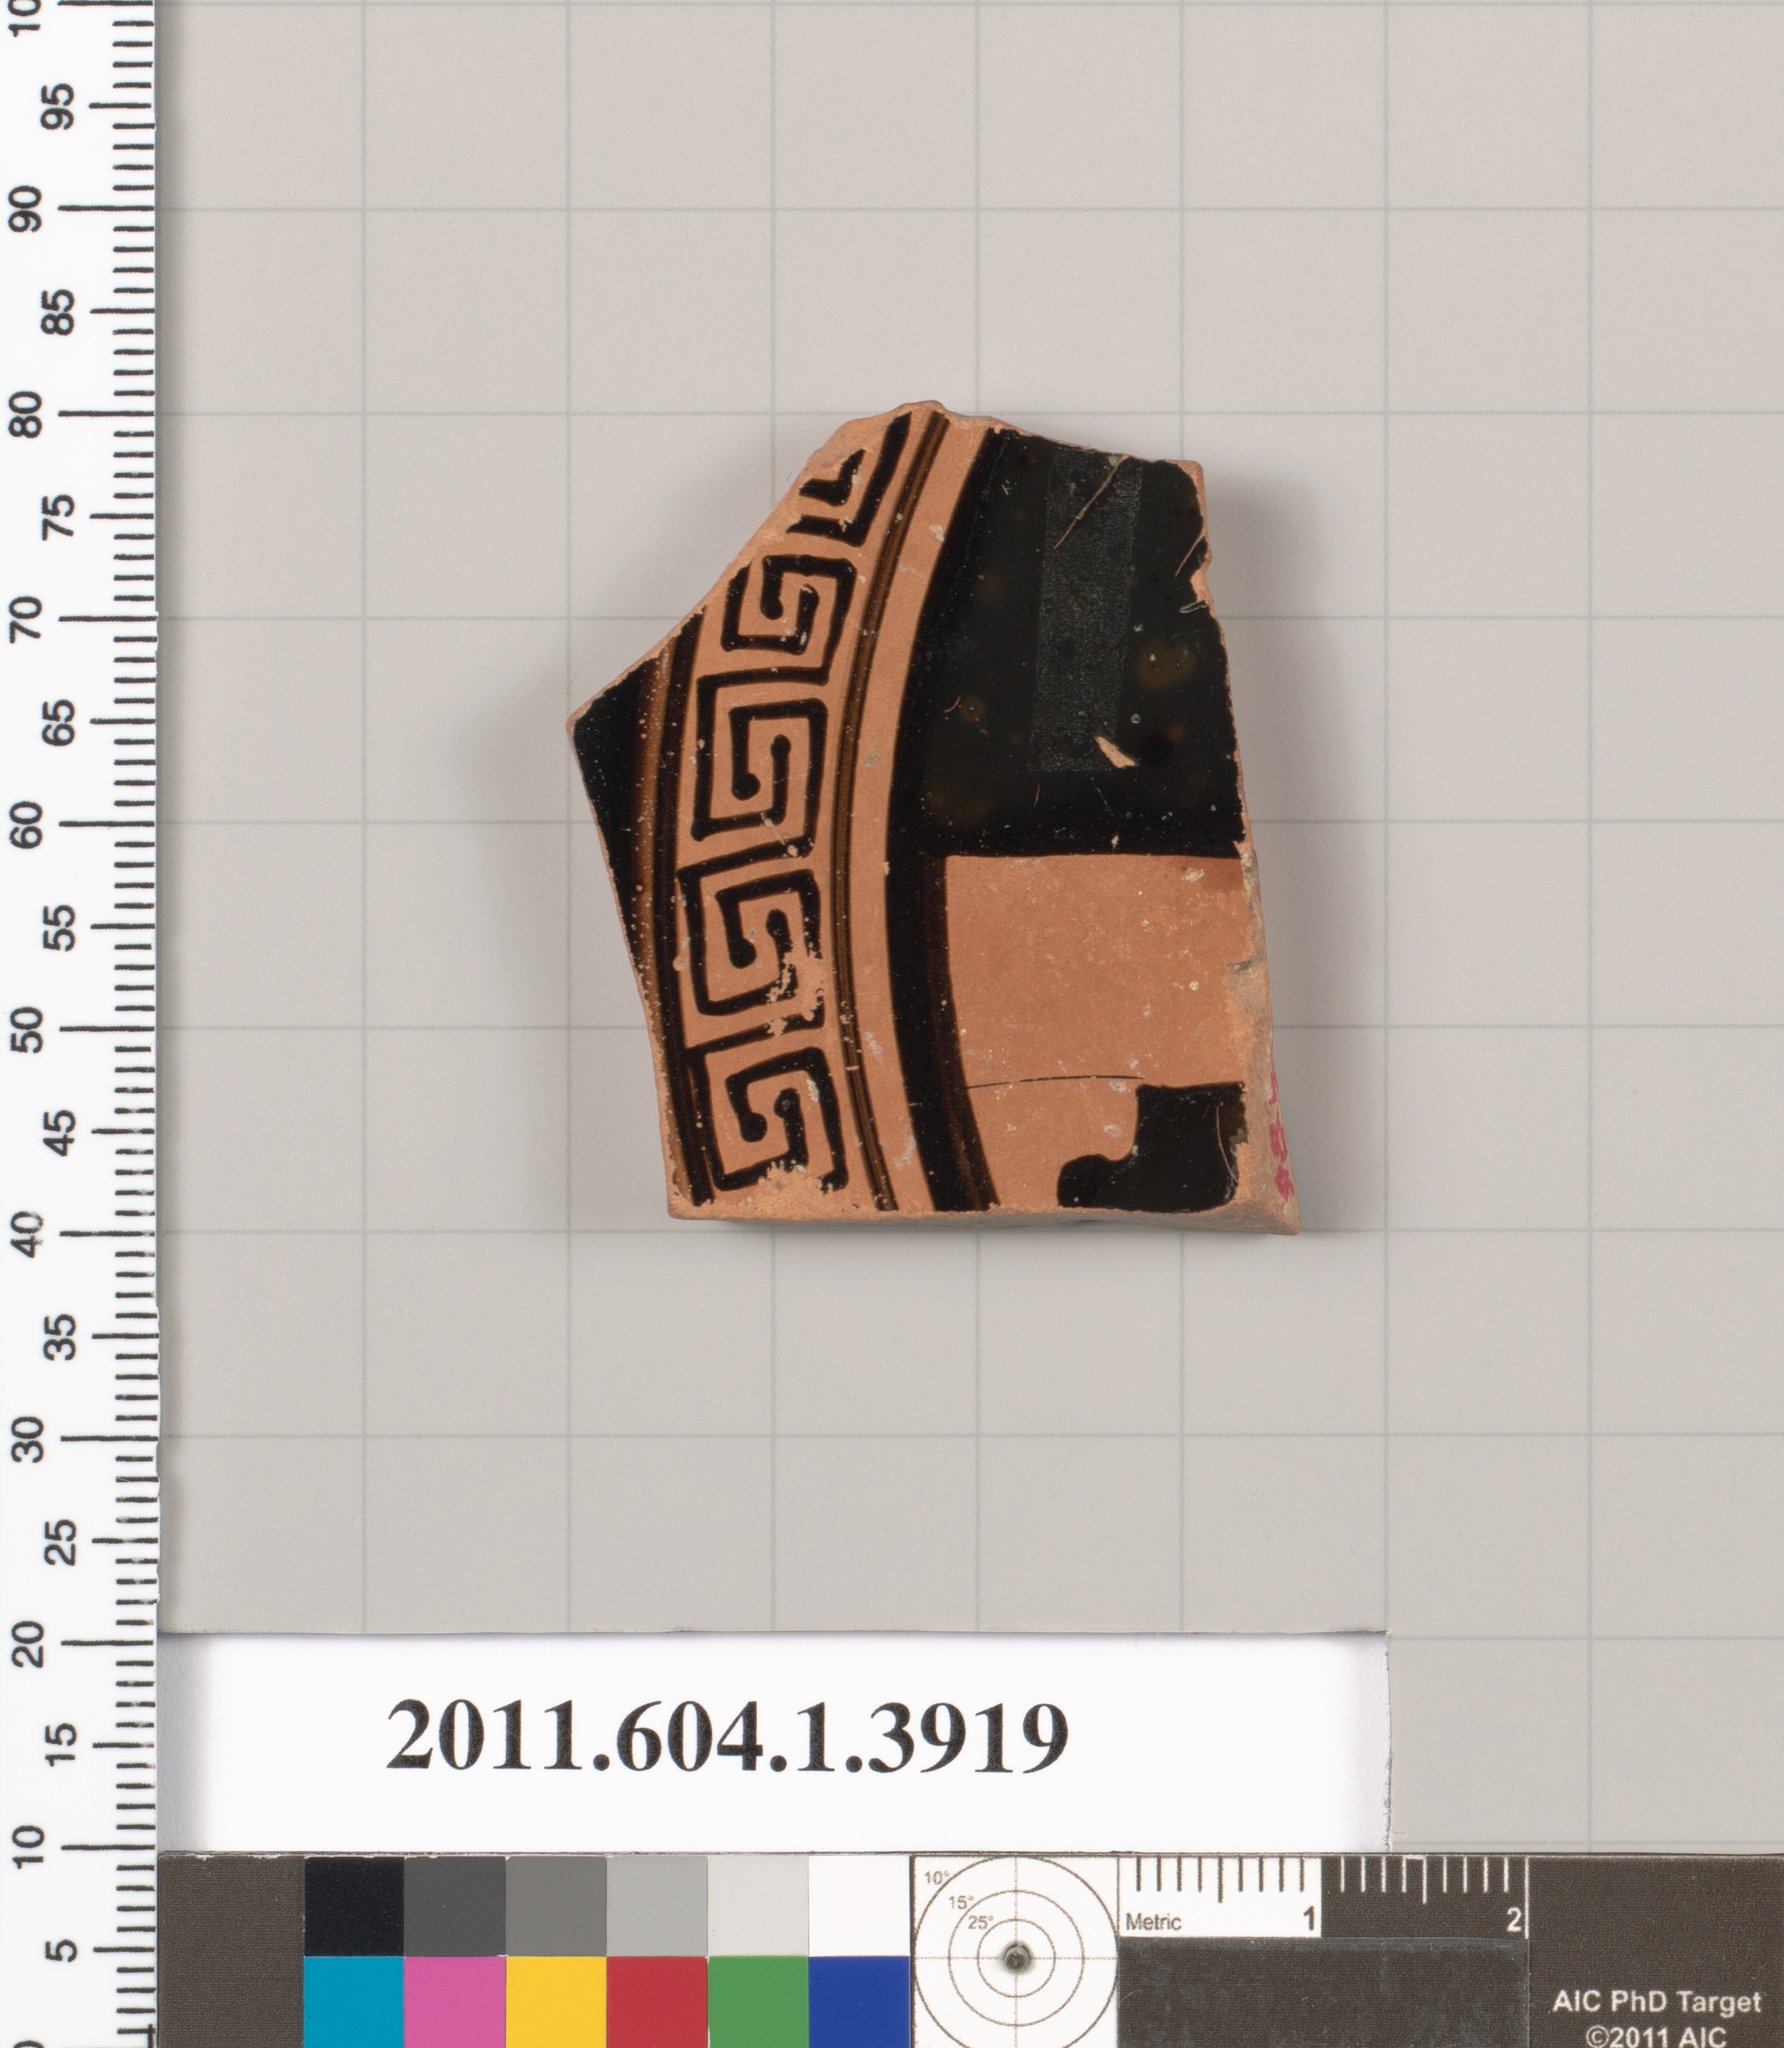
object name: kylix fragment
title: Terracotta fragment of a kylix (drinking cup)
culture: greek, attic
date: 475-451 BCE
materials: terracotta